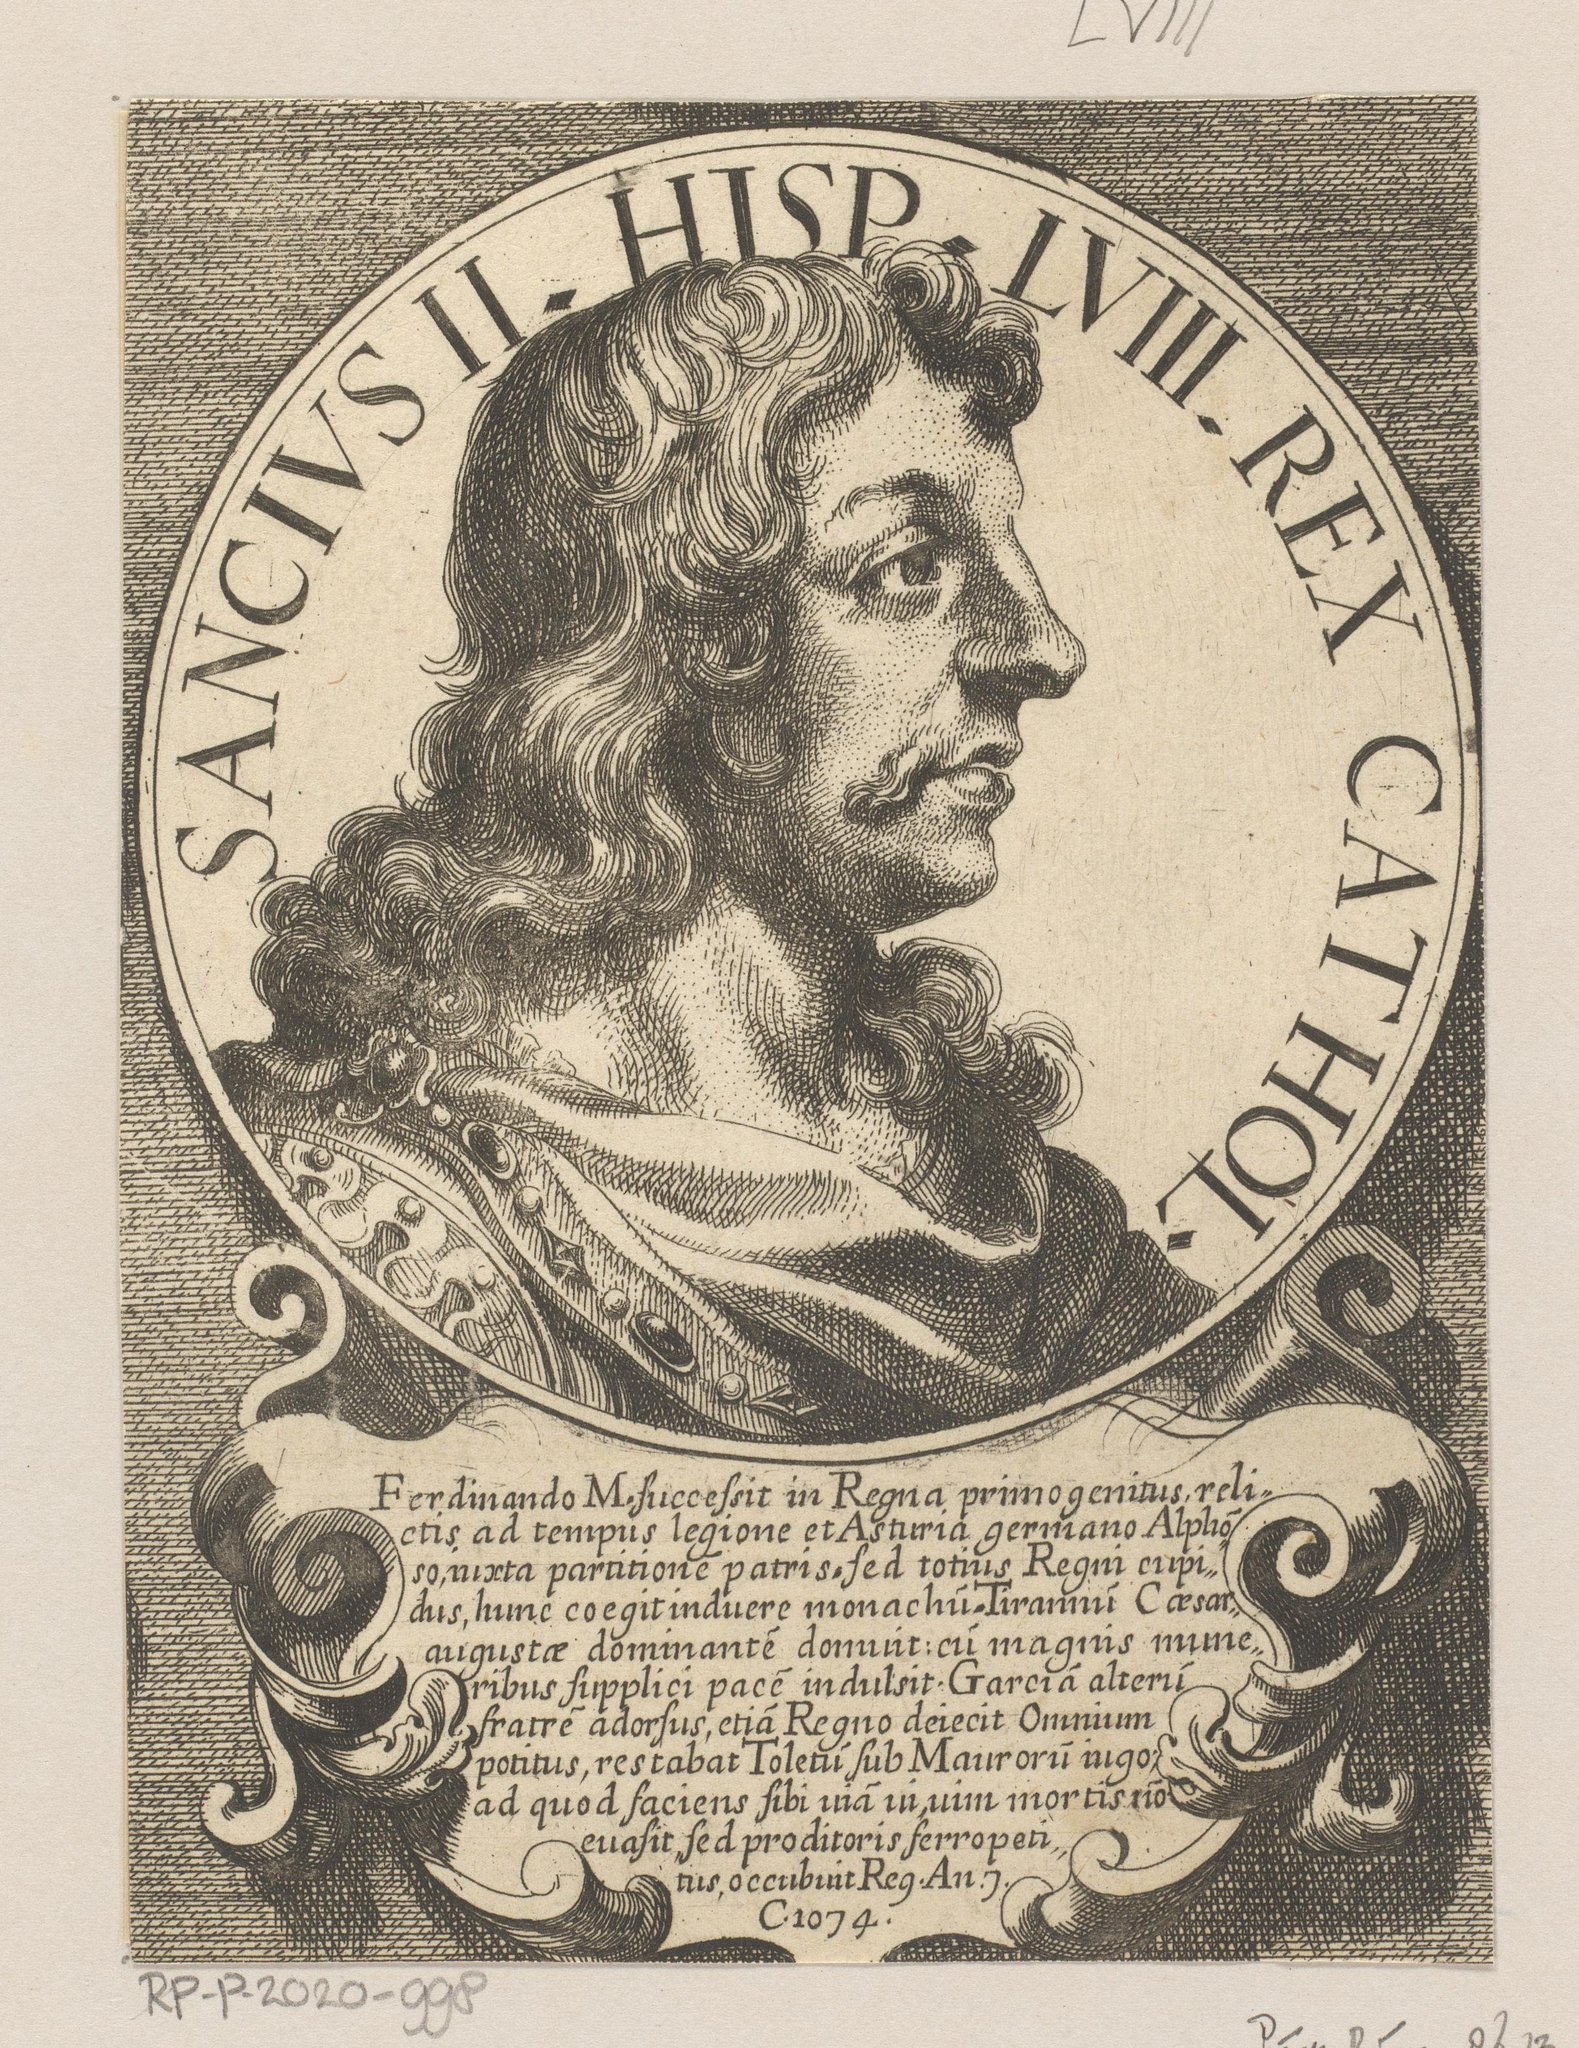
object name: print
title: Portret van Sancho II, koning van Castilië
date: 1684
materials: paper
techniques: engraving, etching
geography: rome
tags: historical persons, ruler, sovereign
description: Portret mogelijk afkomstig van een grote prent, getiteld 'Effigies et series regum Hispaniae primum ex Gothis Christianorum (...)', bestaande uit meerdere bladen die samengevoegd konden worden, uitgegeven door Giovanni Giacomo de' Rossi in 1684.